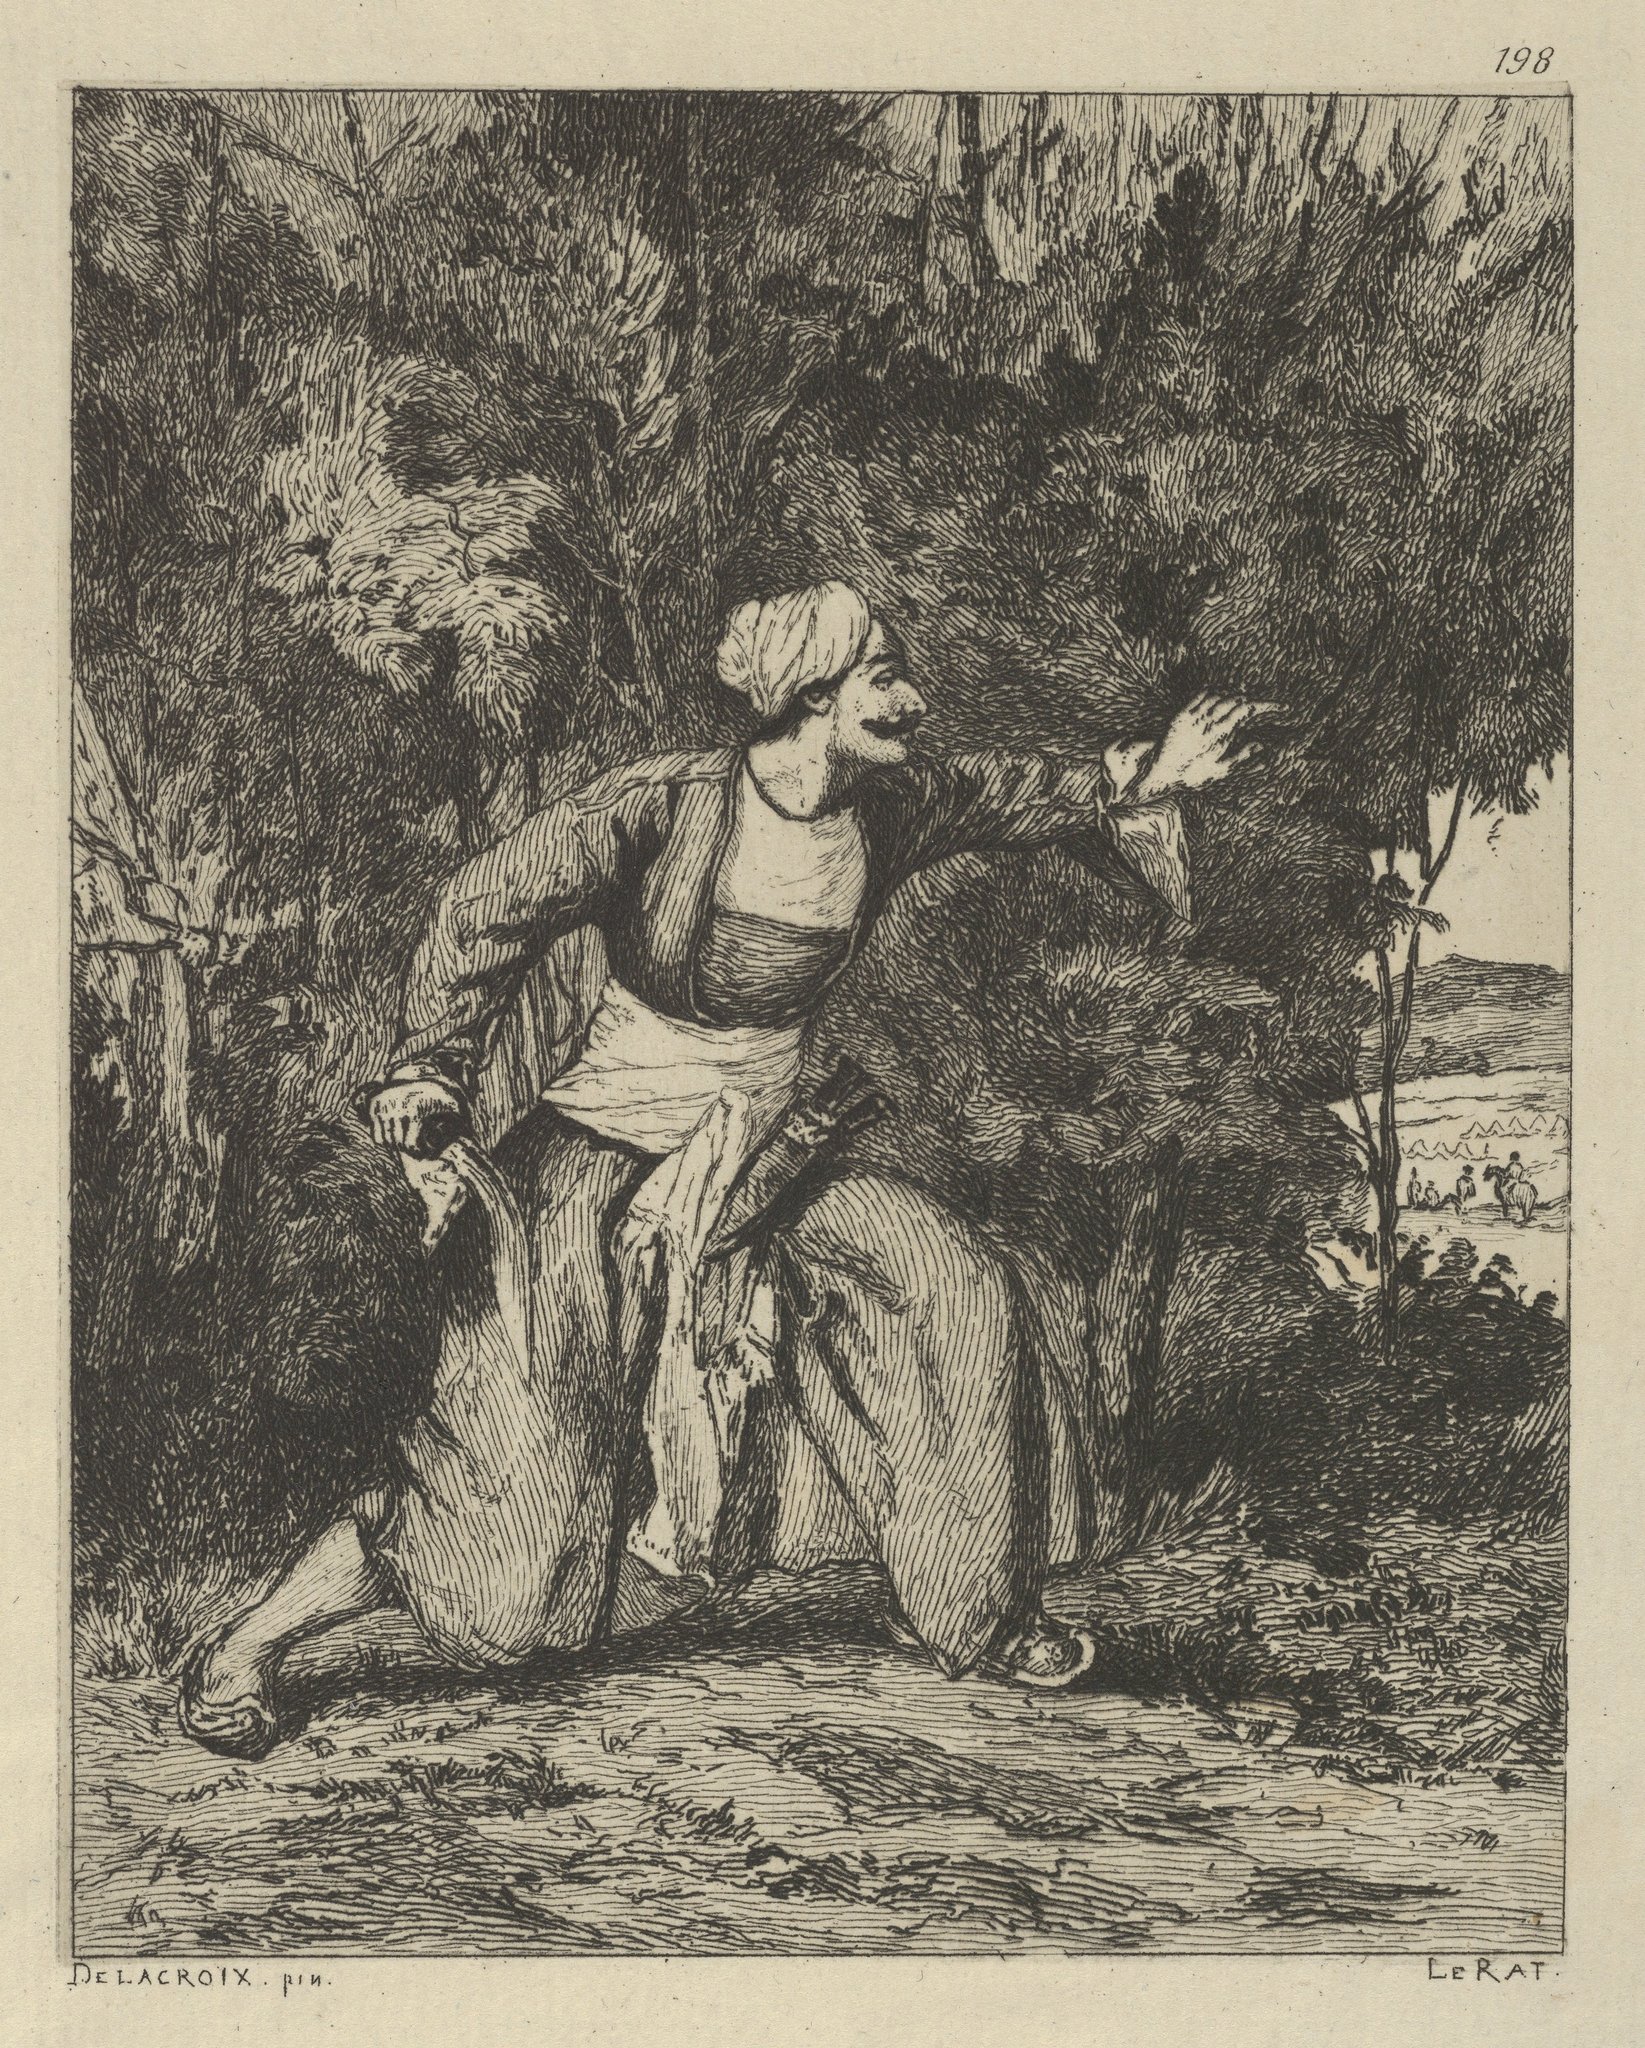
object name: print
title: Indian in an Ambush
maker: paul-edme le rat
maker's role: engraver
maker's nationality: french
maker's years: 1849-1892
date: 1801-1900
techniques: etching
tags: daggers,men,trees